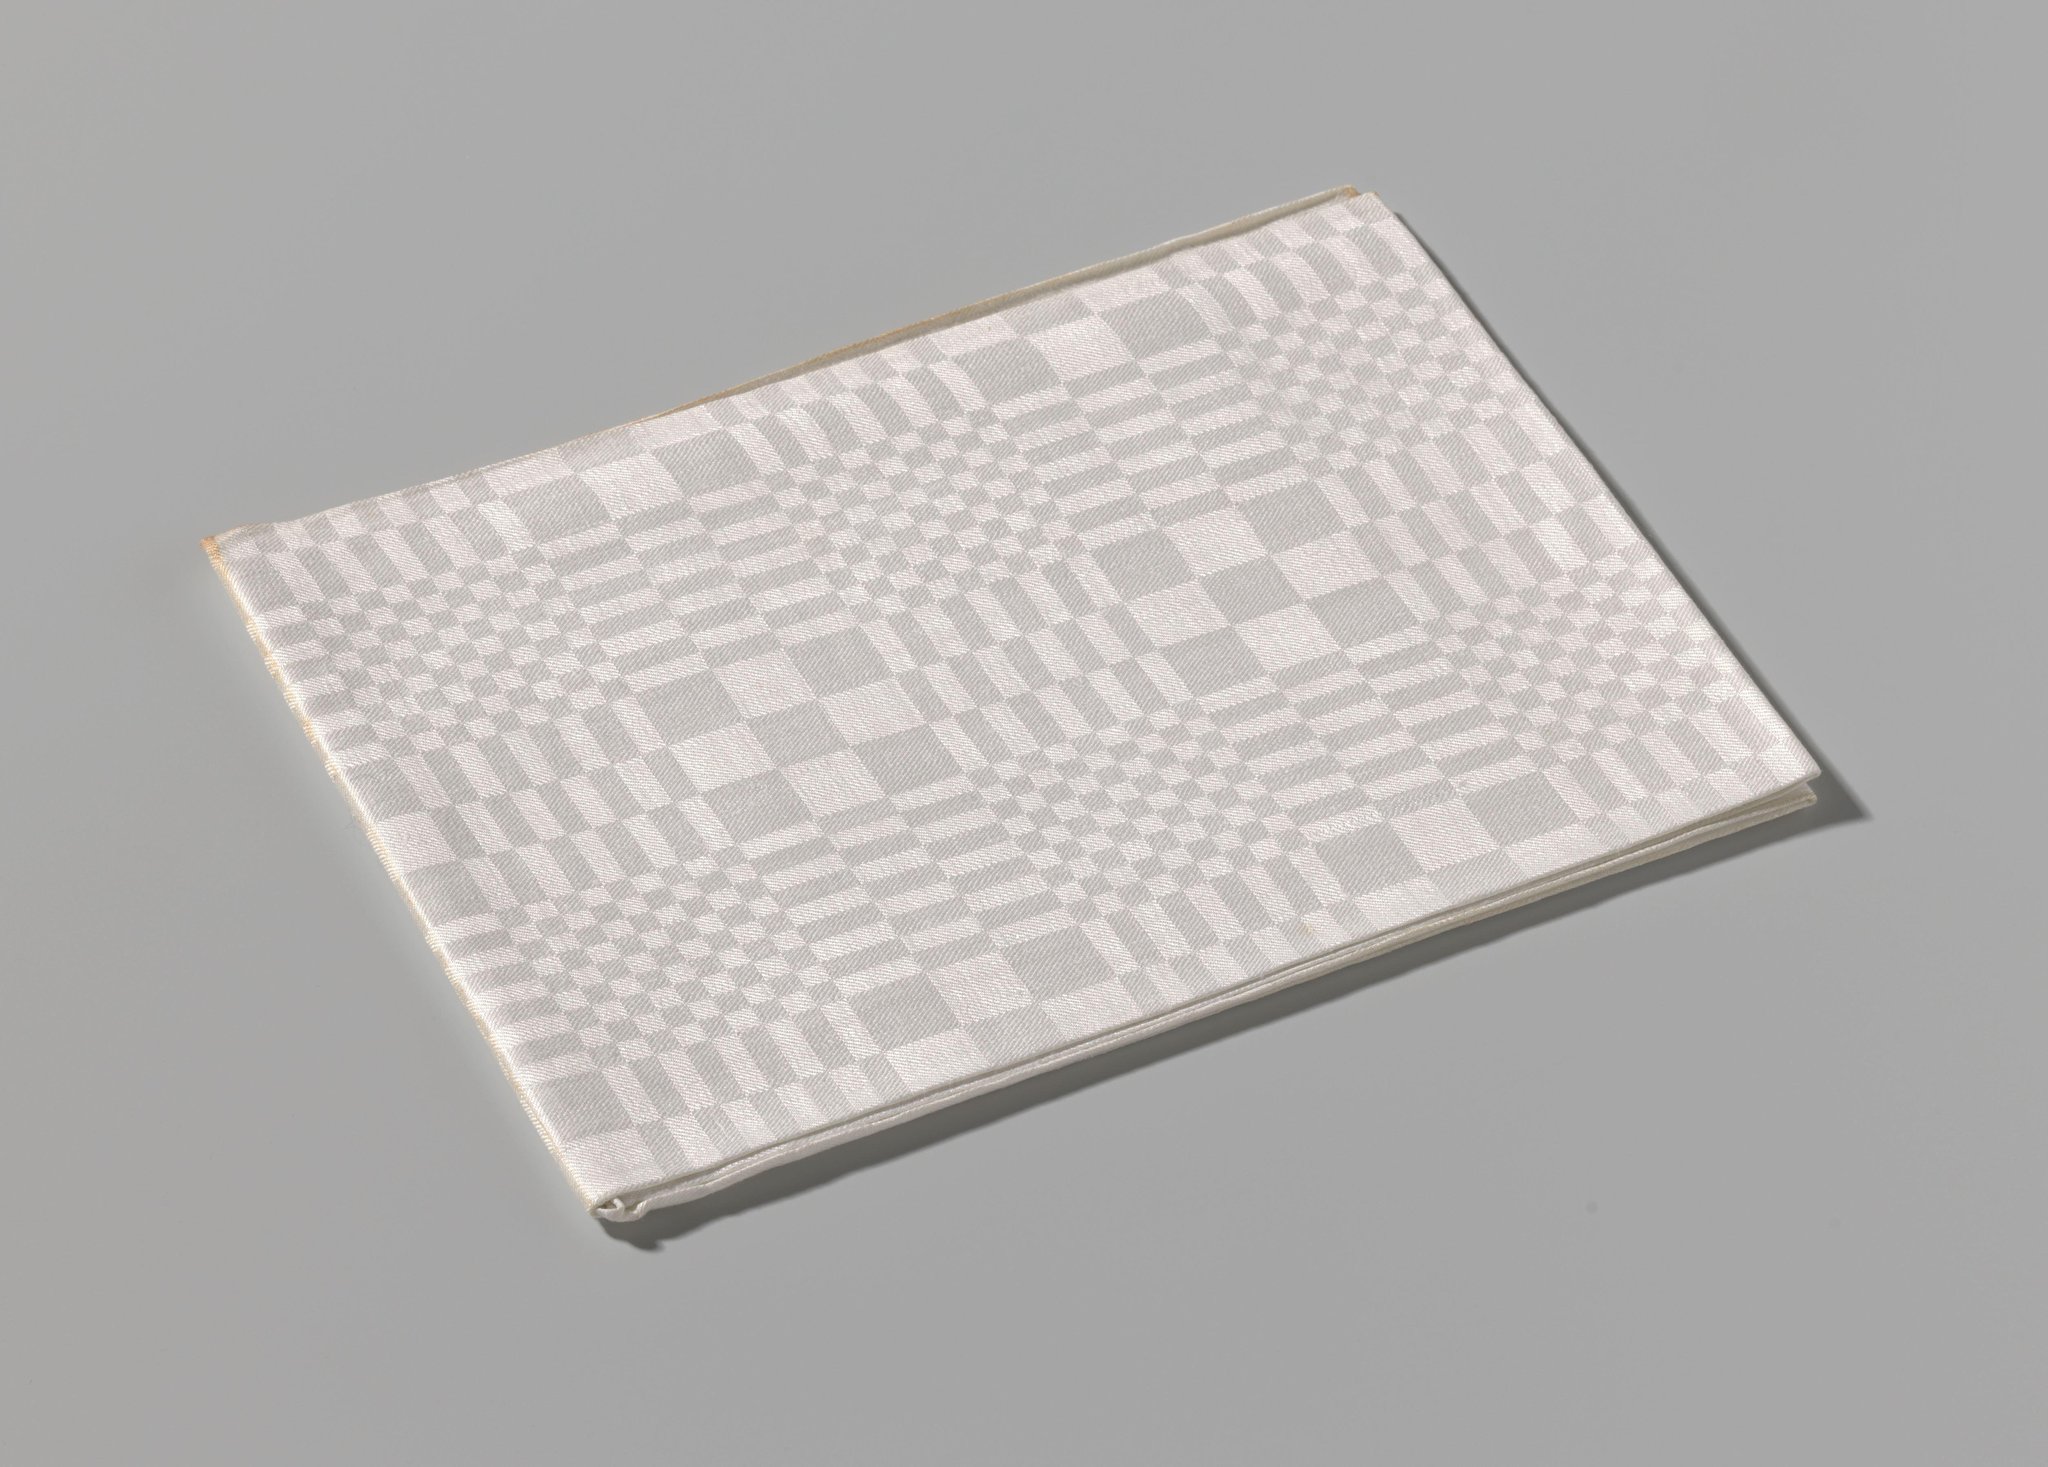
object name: napkin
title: Servet van linnen met pellenpatroon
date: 1784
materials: linen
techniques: twill, peeled fabric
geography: northern netherlands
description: wit linnen servet met pellen patroon, z.g. Engelse garderobe, merk WS 104 en 1784